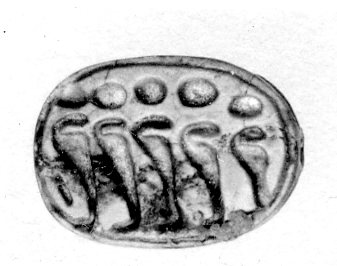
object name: scarab, uraei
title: Scarab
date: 1479-1425 BCE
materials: glass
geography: upper egypt, thebes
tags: scarabs